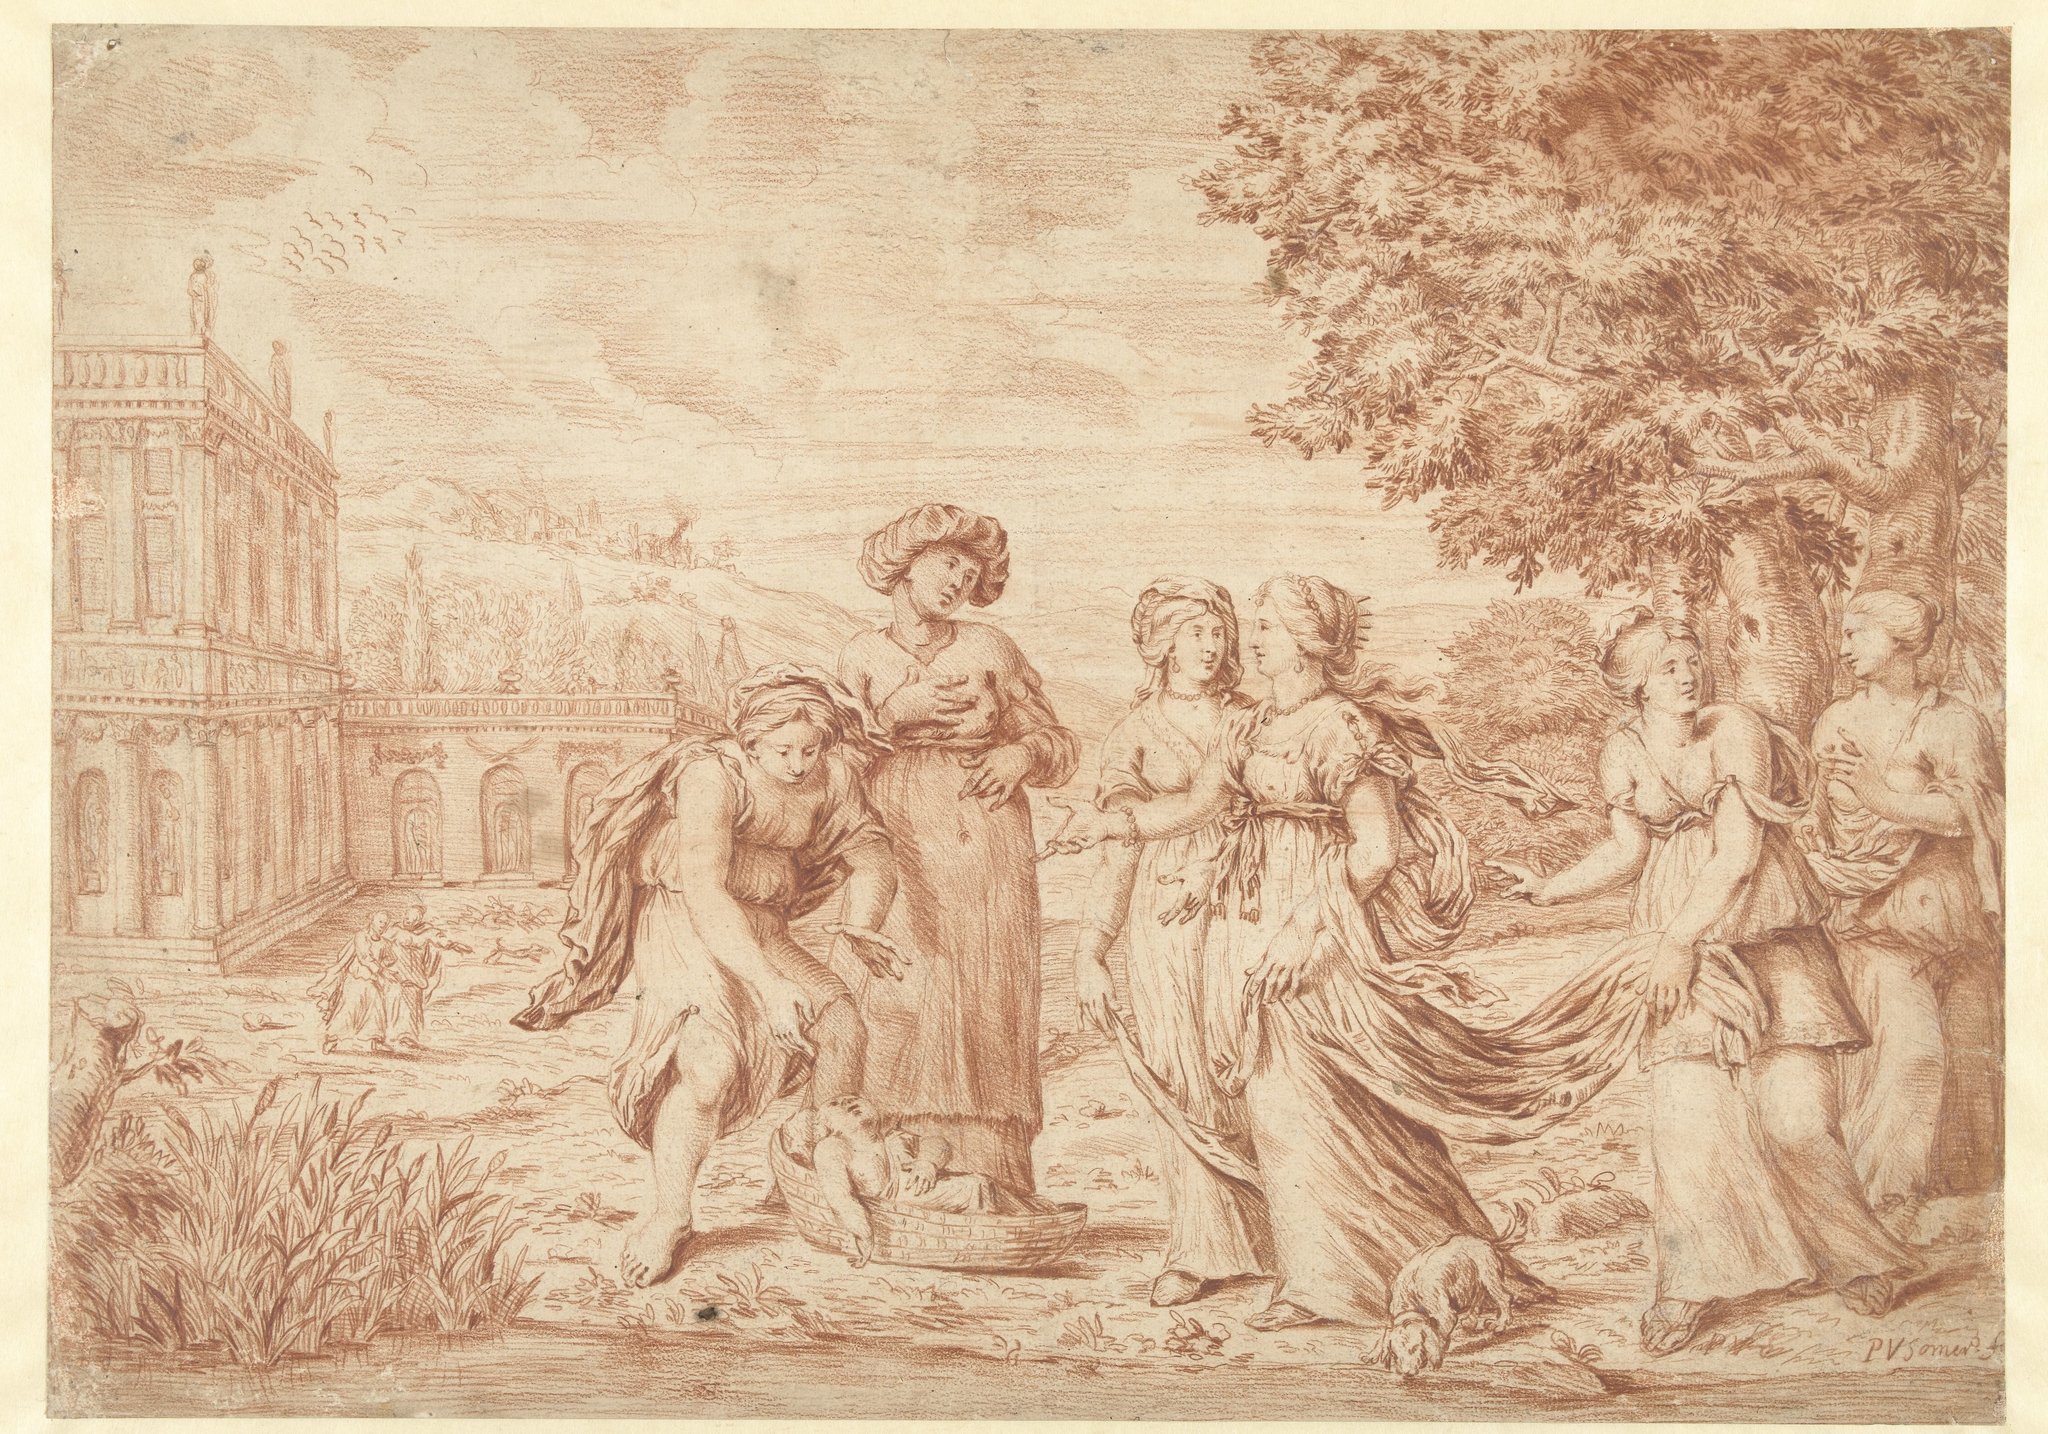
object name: drawing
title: Dochter van Farao vindt Mozes in het biezenmandje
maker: paul van somer (ii)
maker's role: draughtsman, print maker, publisher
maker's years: 1639-1704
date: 1659-1694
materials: chalk, paper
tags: miriam induces pharaoh's daughter to entrust moses to a hebrew nurse